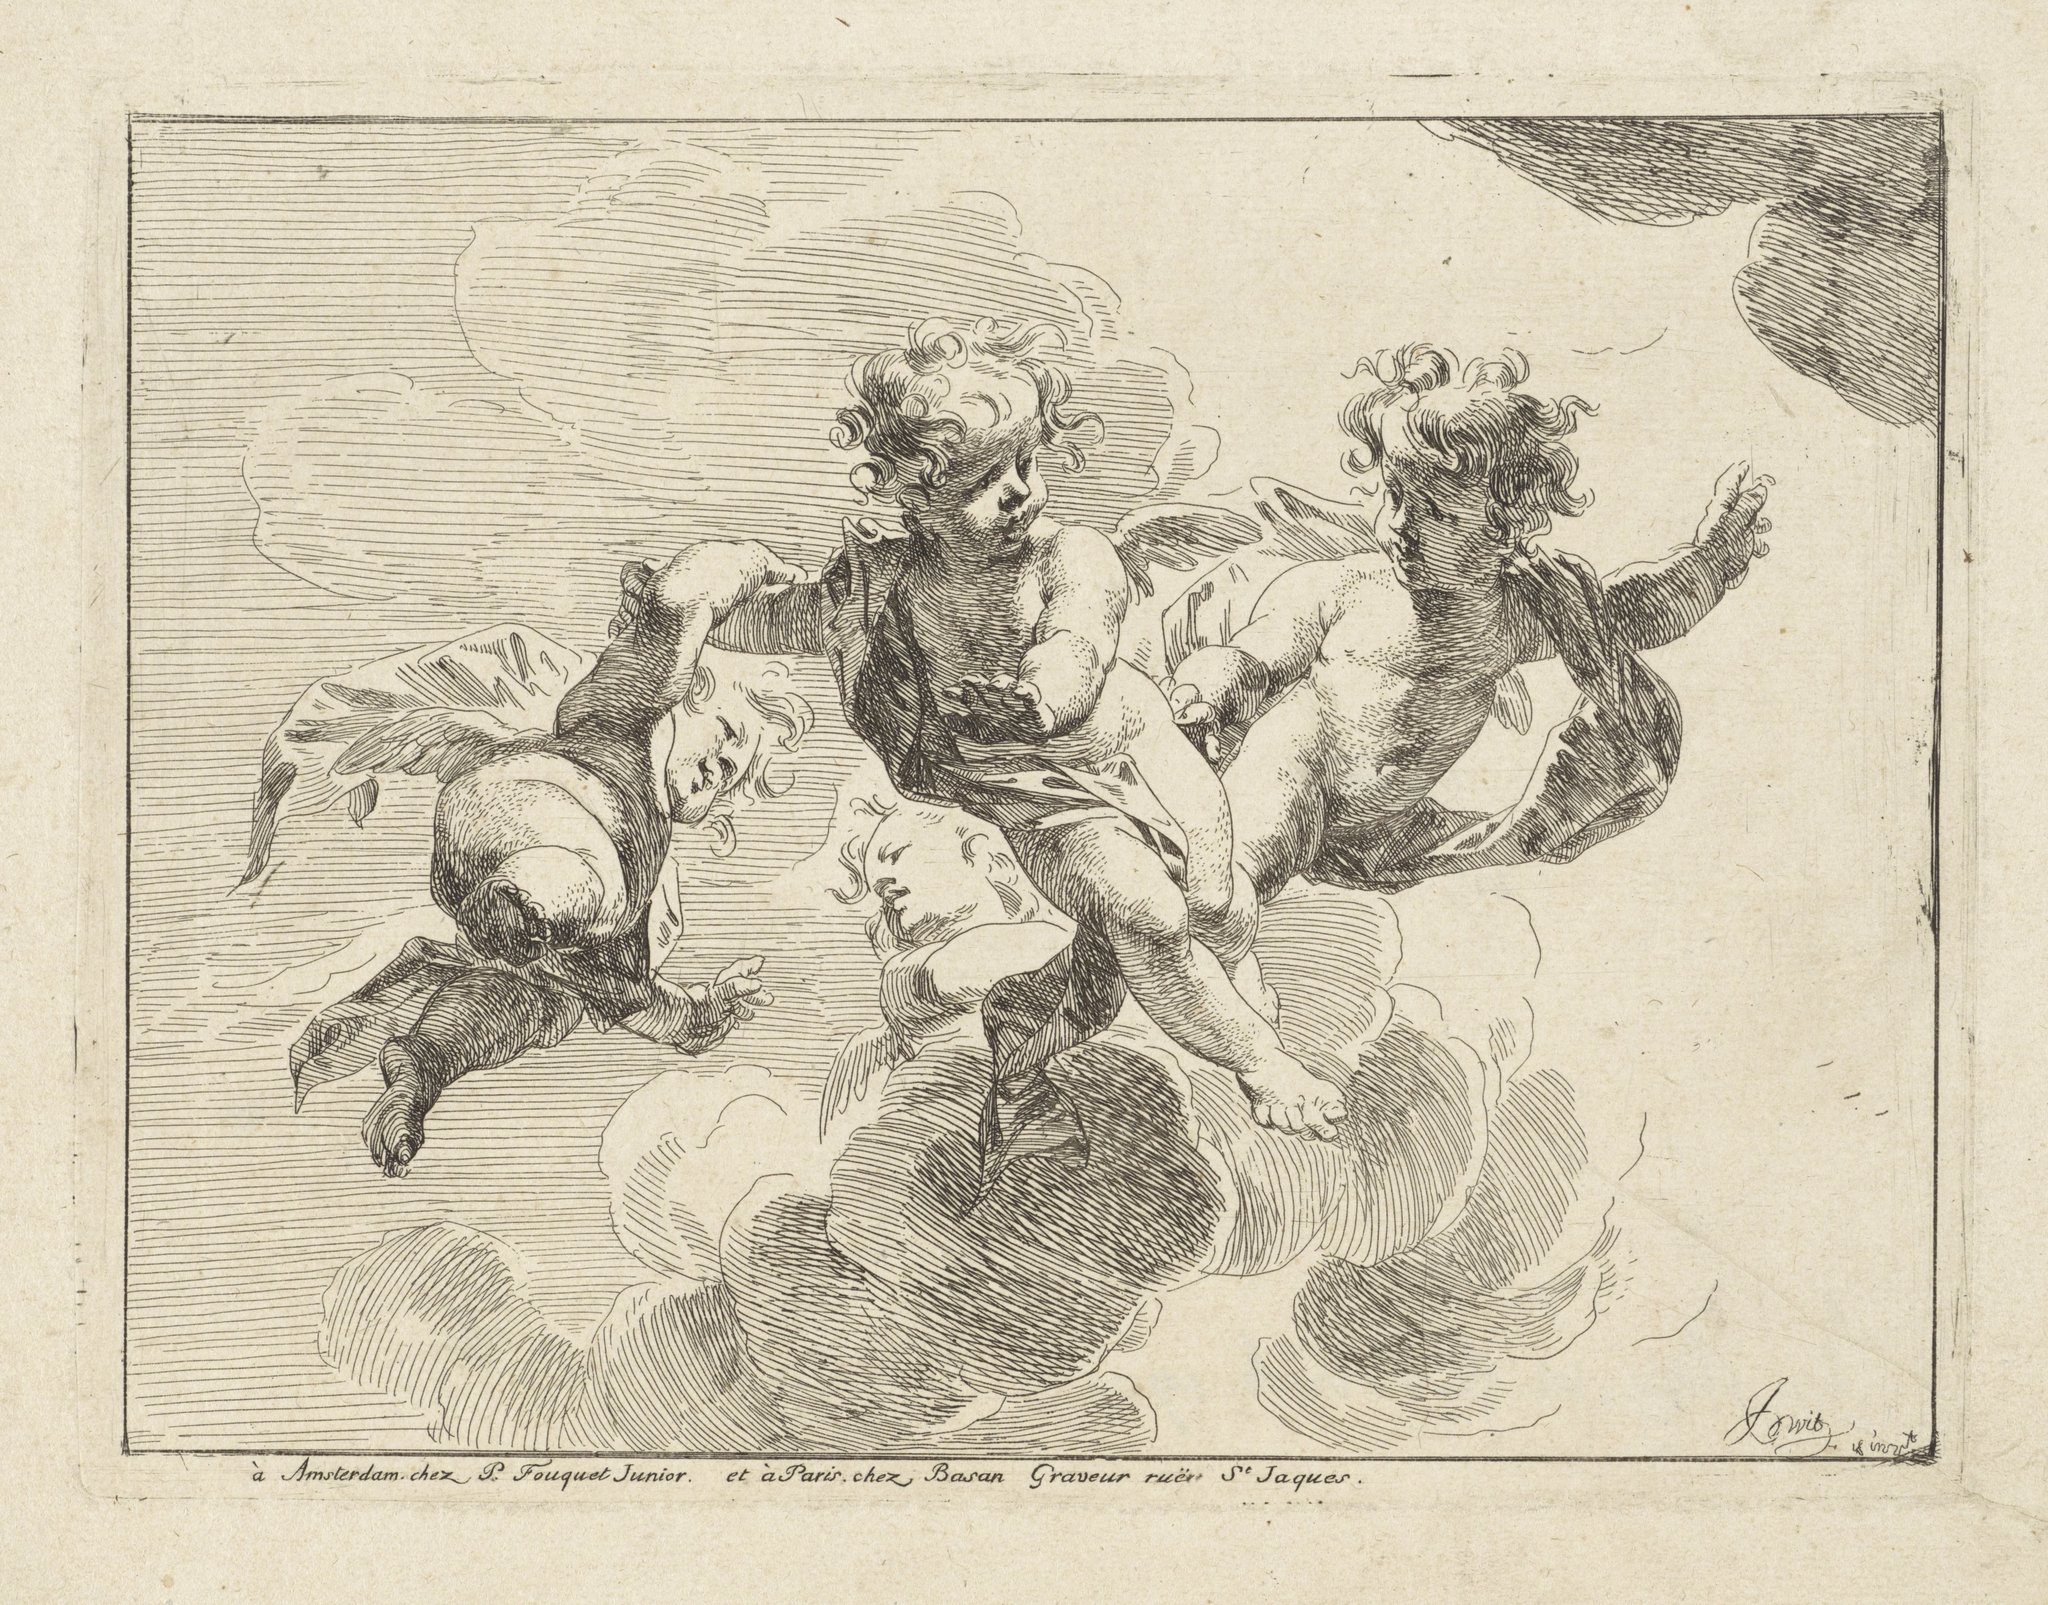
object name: print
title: Vier putti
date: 1705-1754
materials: paper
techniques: etching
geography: paris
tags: cupids: 'amores', 'amoretti', 'putti'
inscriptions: collector's mark: Lugt 2228